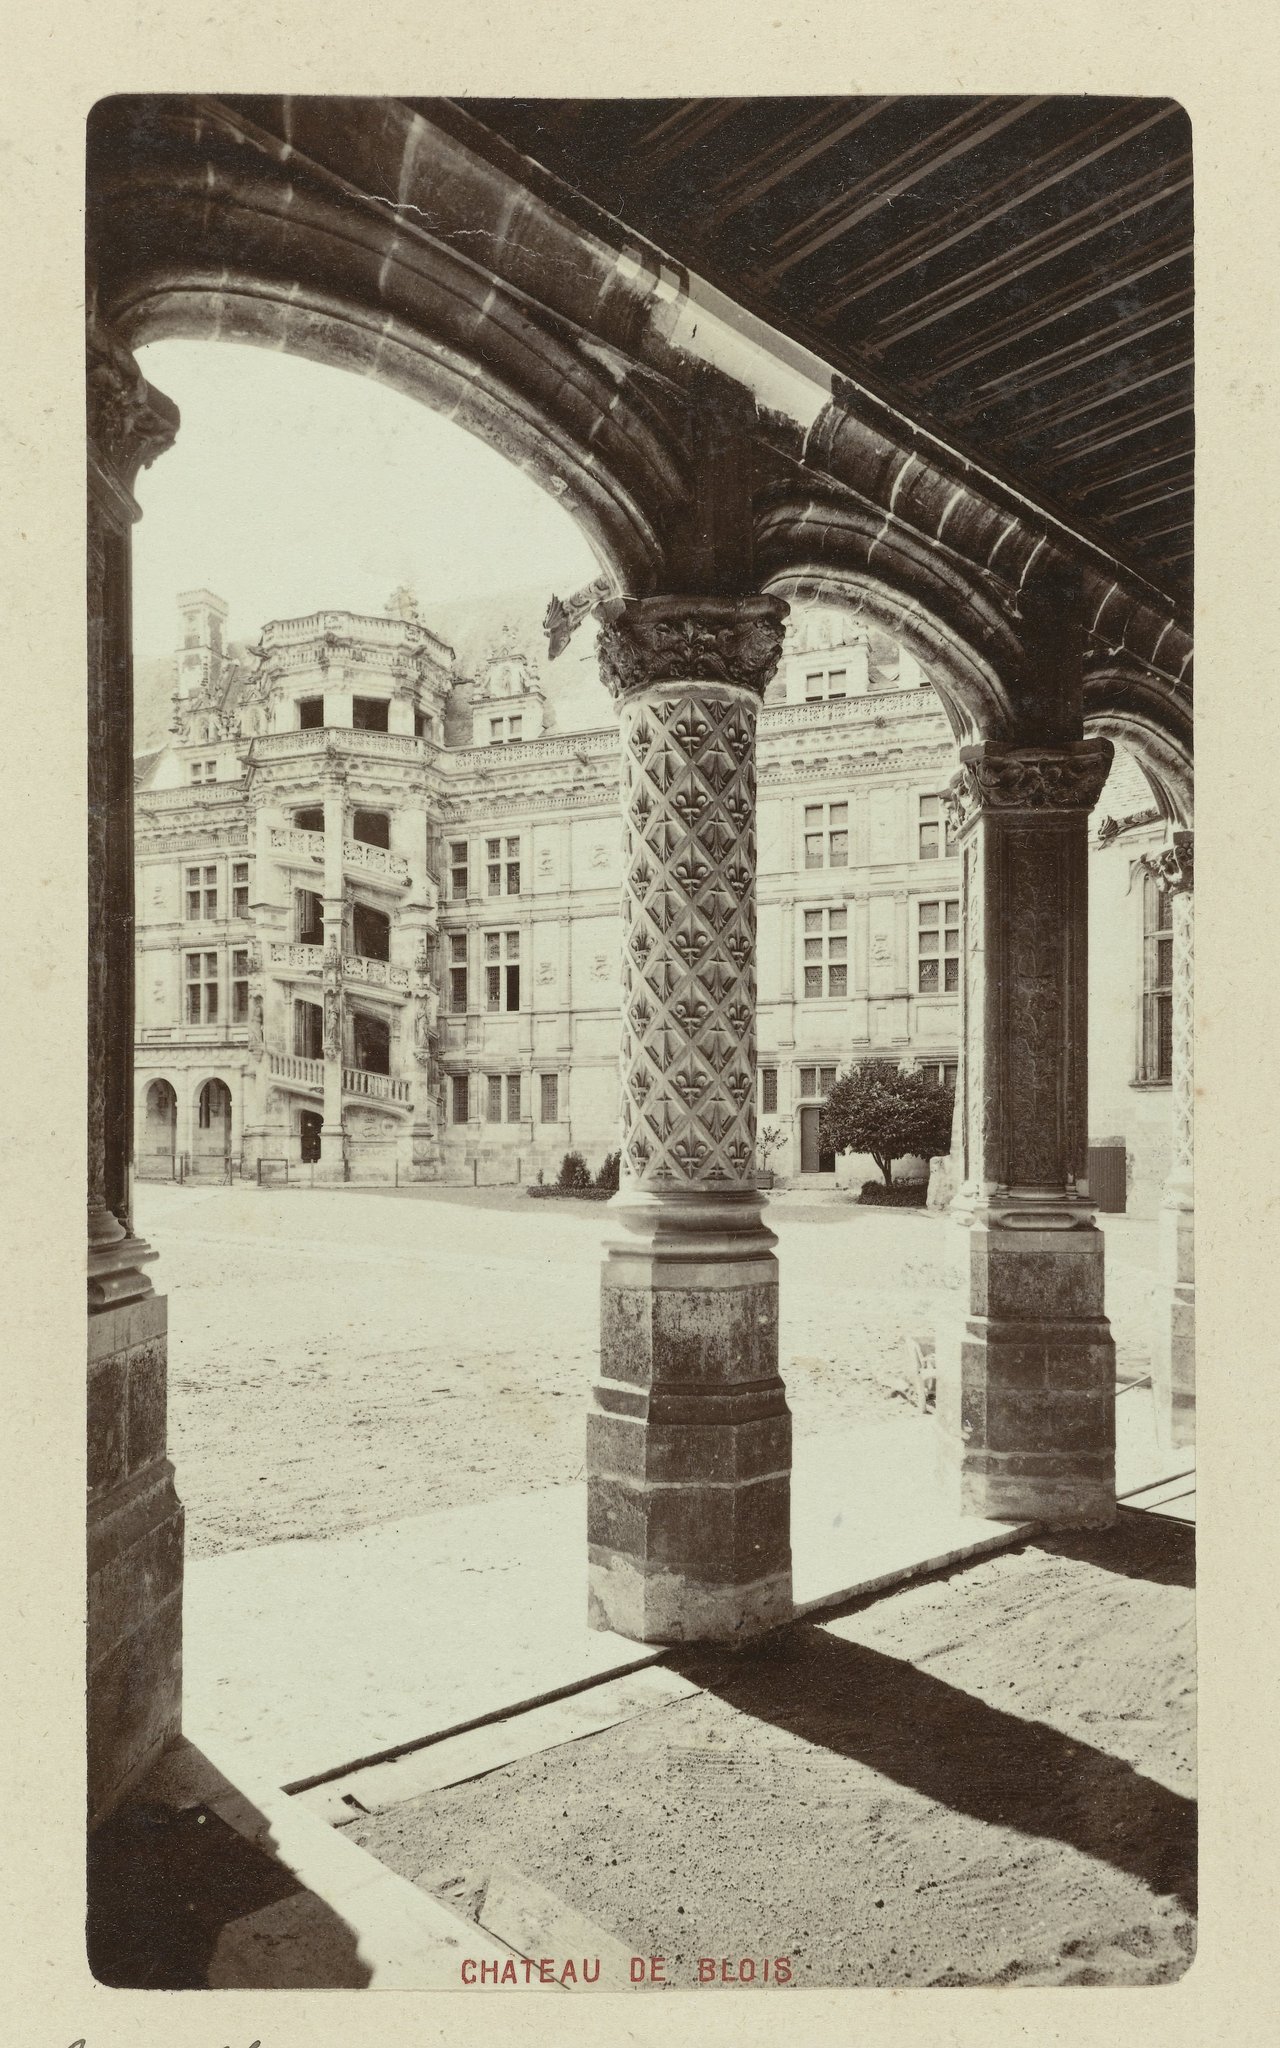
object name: photograph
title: Château de Blois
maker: Anonymous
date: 1865-1875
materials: cardboard, paper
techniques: albumen print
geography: château de blois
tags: stairwell, palace, inner court of palace or 'hôtel'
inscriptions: inscription: ‘Looking from the/ Louis XII part of the/ Château, to the Grand/ Staircase of Francis I’, inscription: ‘5,-’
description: Detail van het kasteel van Blois. De wenteltrap van de vleugel van Frans I gezien door de bogen van de vleugel van Lodewijk XII.